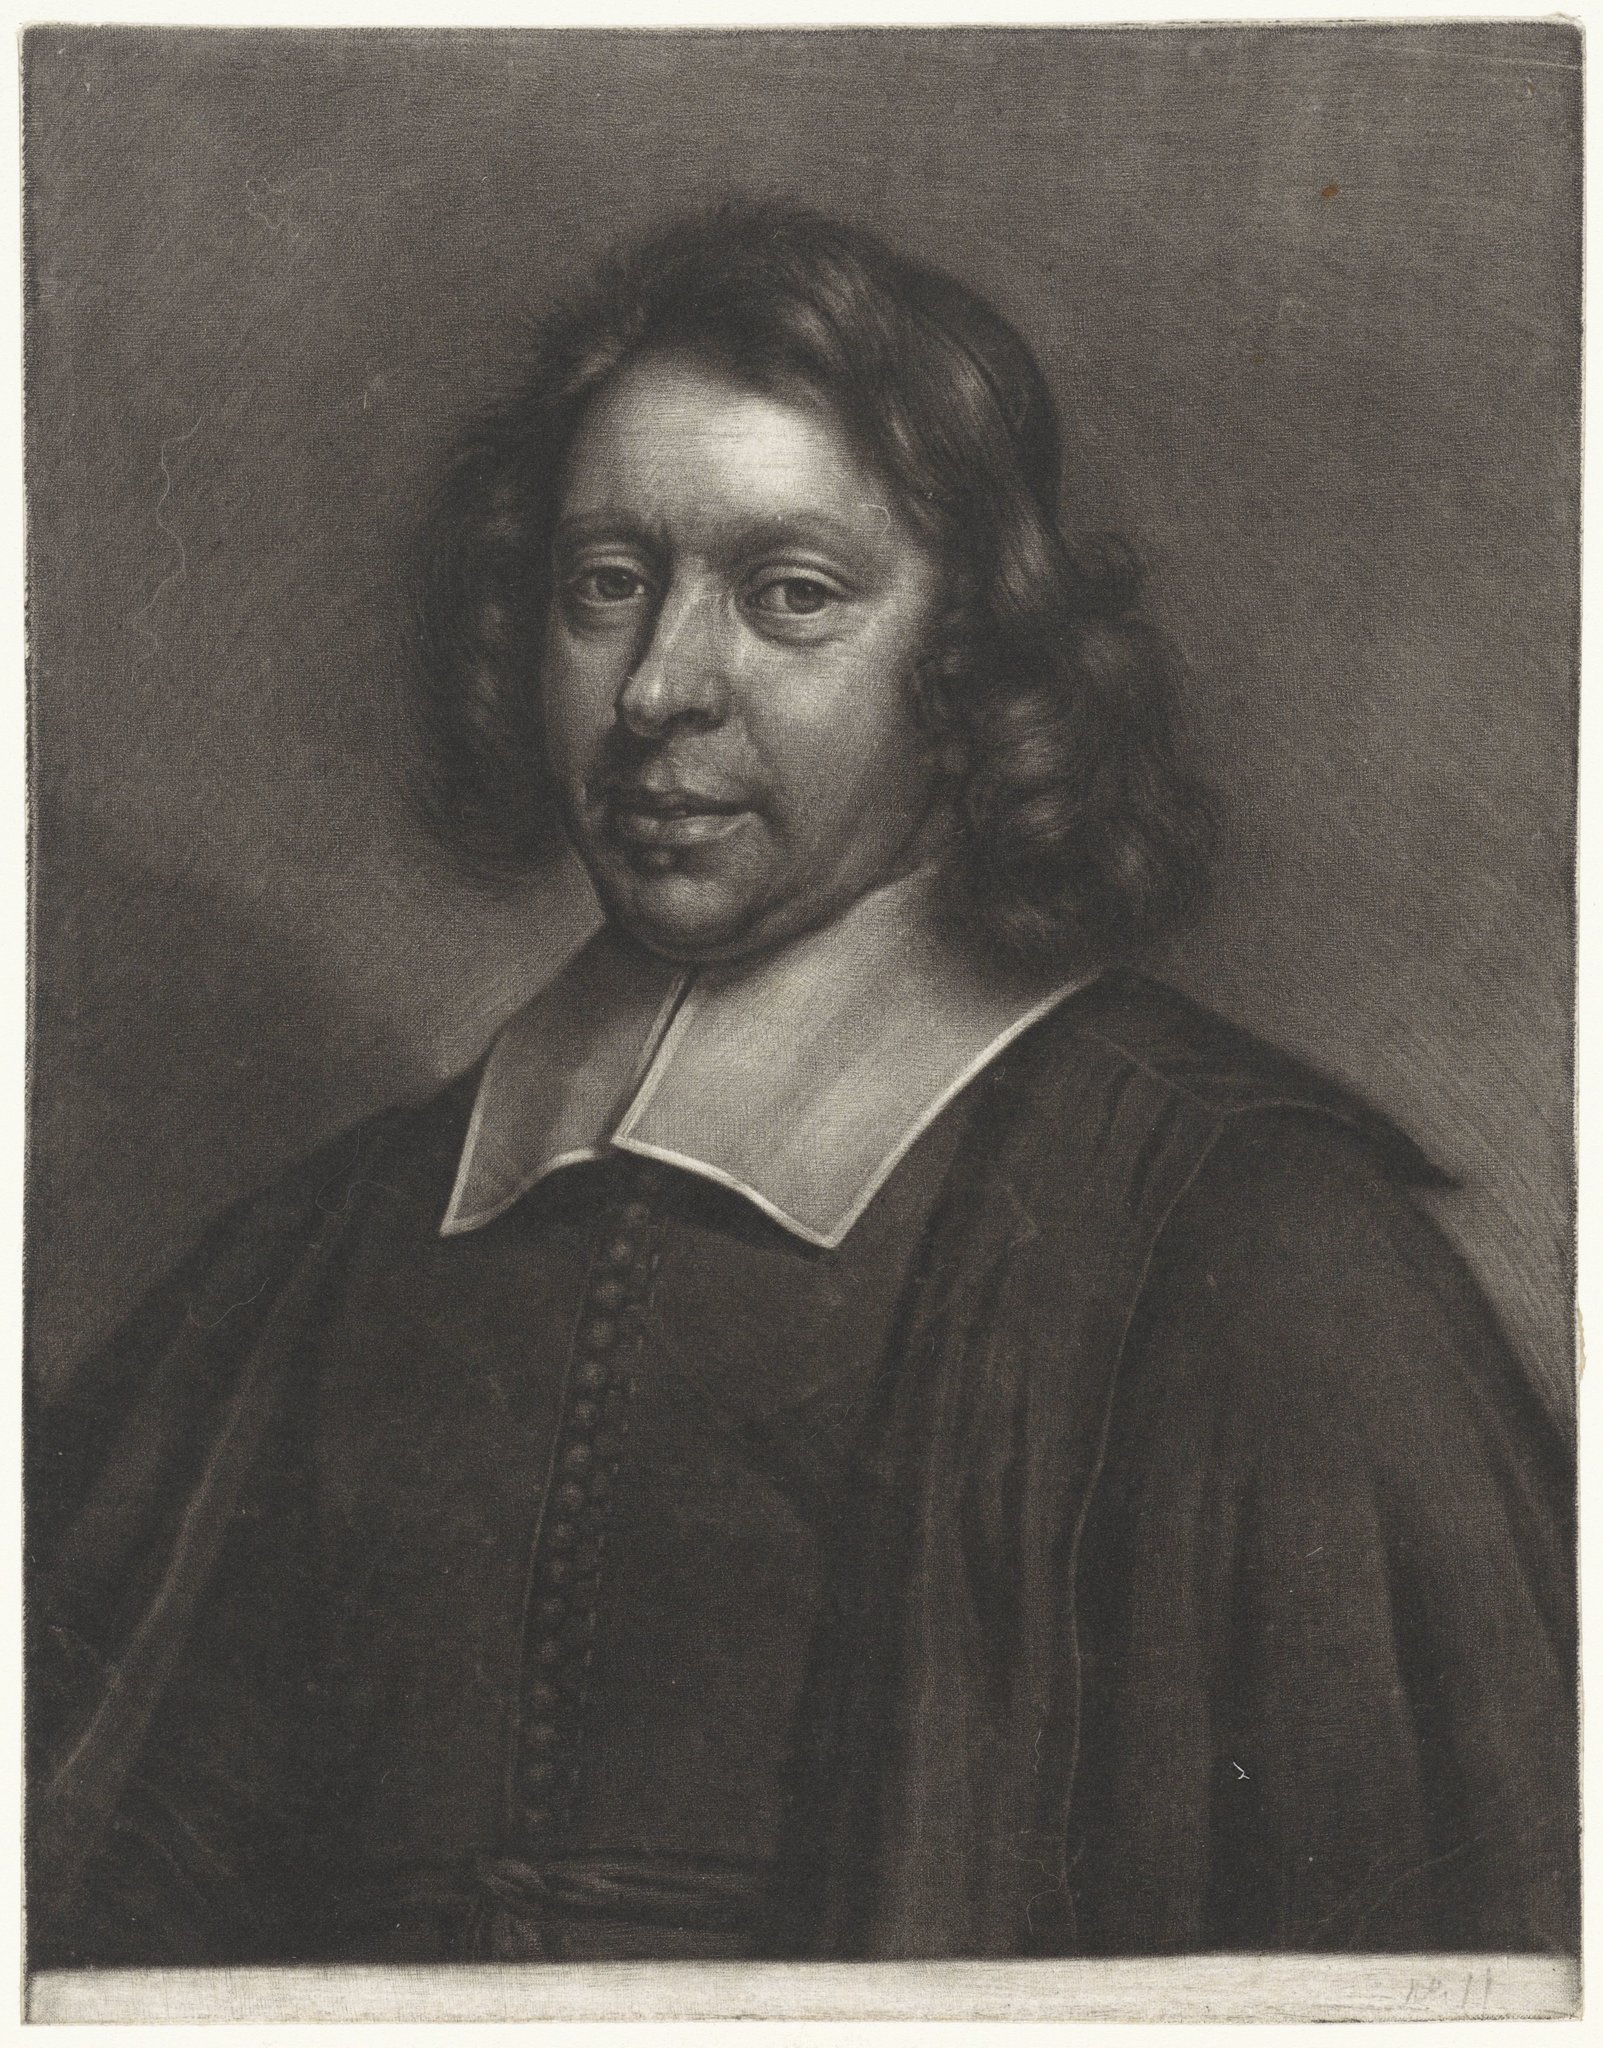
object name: print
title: Portret van een man, mogelijk de predikant Hendrick Blancheteste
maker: wallerant vaillant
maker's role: draughtsman, painter, print maker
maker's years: 1623-1677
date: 1658-1677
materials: paper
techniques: mezzotint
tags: hendrick blancheteste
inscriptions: collector's mark: Lugt 2228